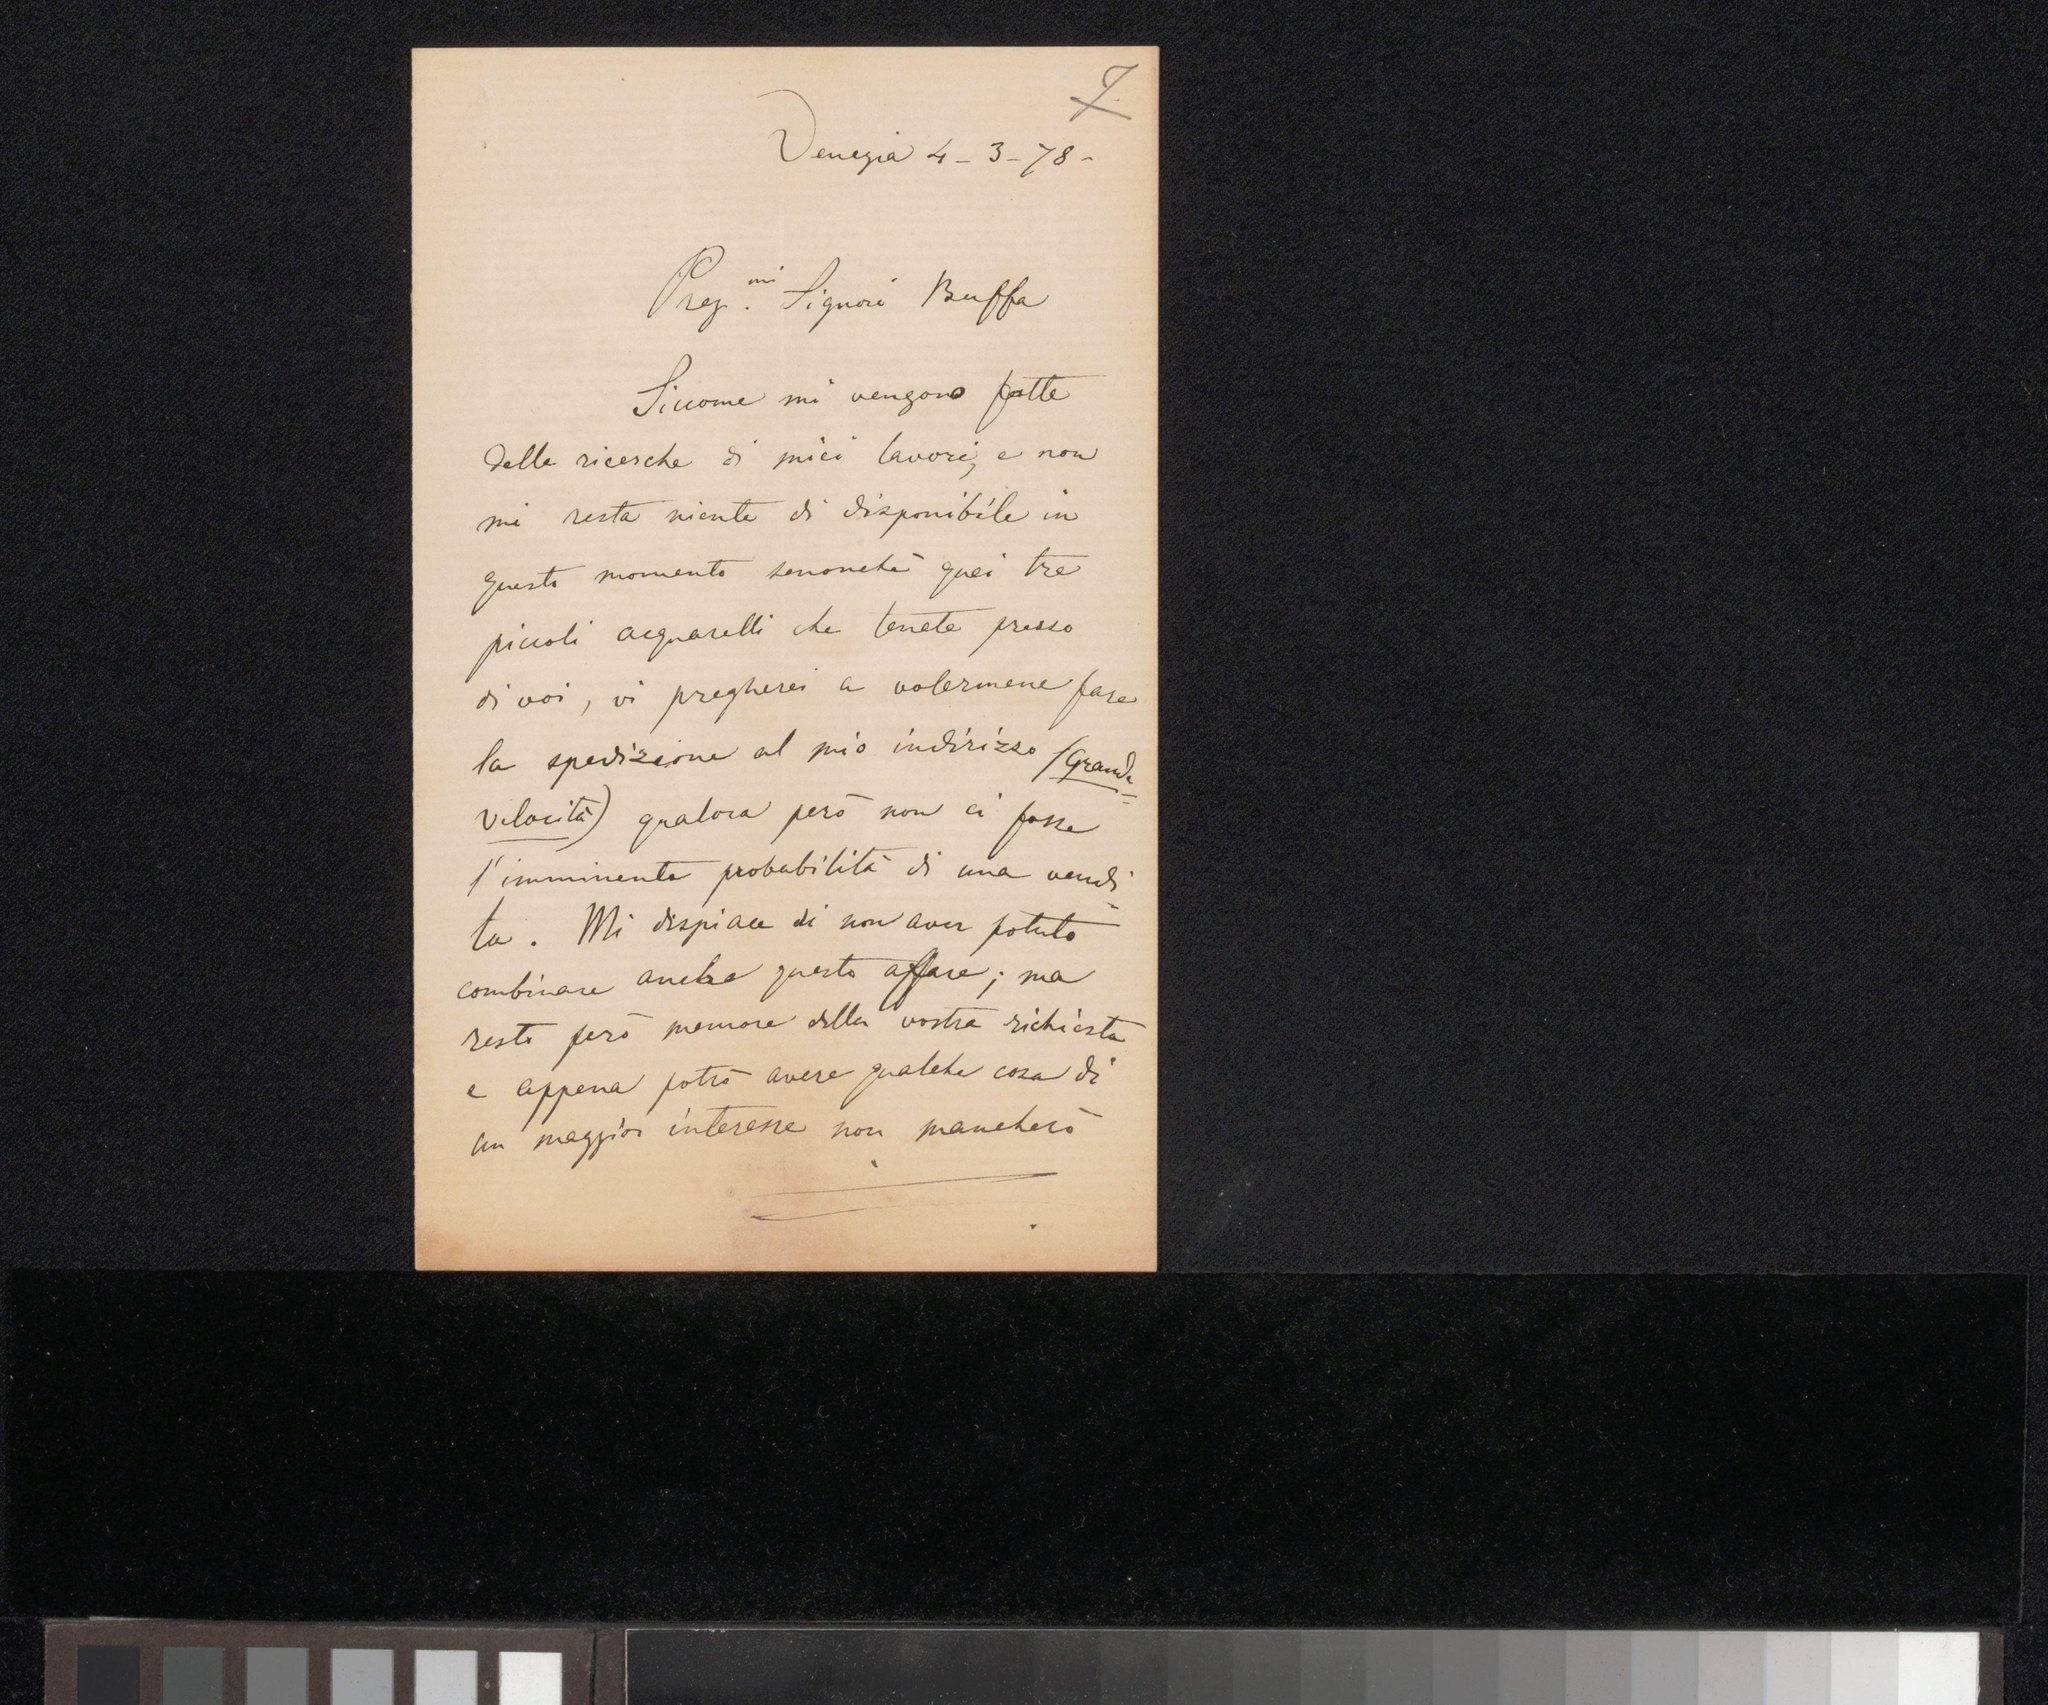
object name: letter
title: Brief aan Frans Buffa en Zonen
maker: silvio giulio rotta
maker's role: painter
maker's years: 1853-1913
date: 1878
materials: ink, paper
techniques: pen, writing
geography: venice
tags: art trade, art shop, drawing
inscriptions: collector's mark: Lugt 2233